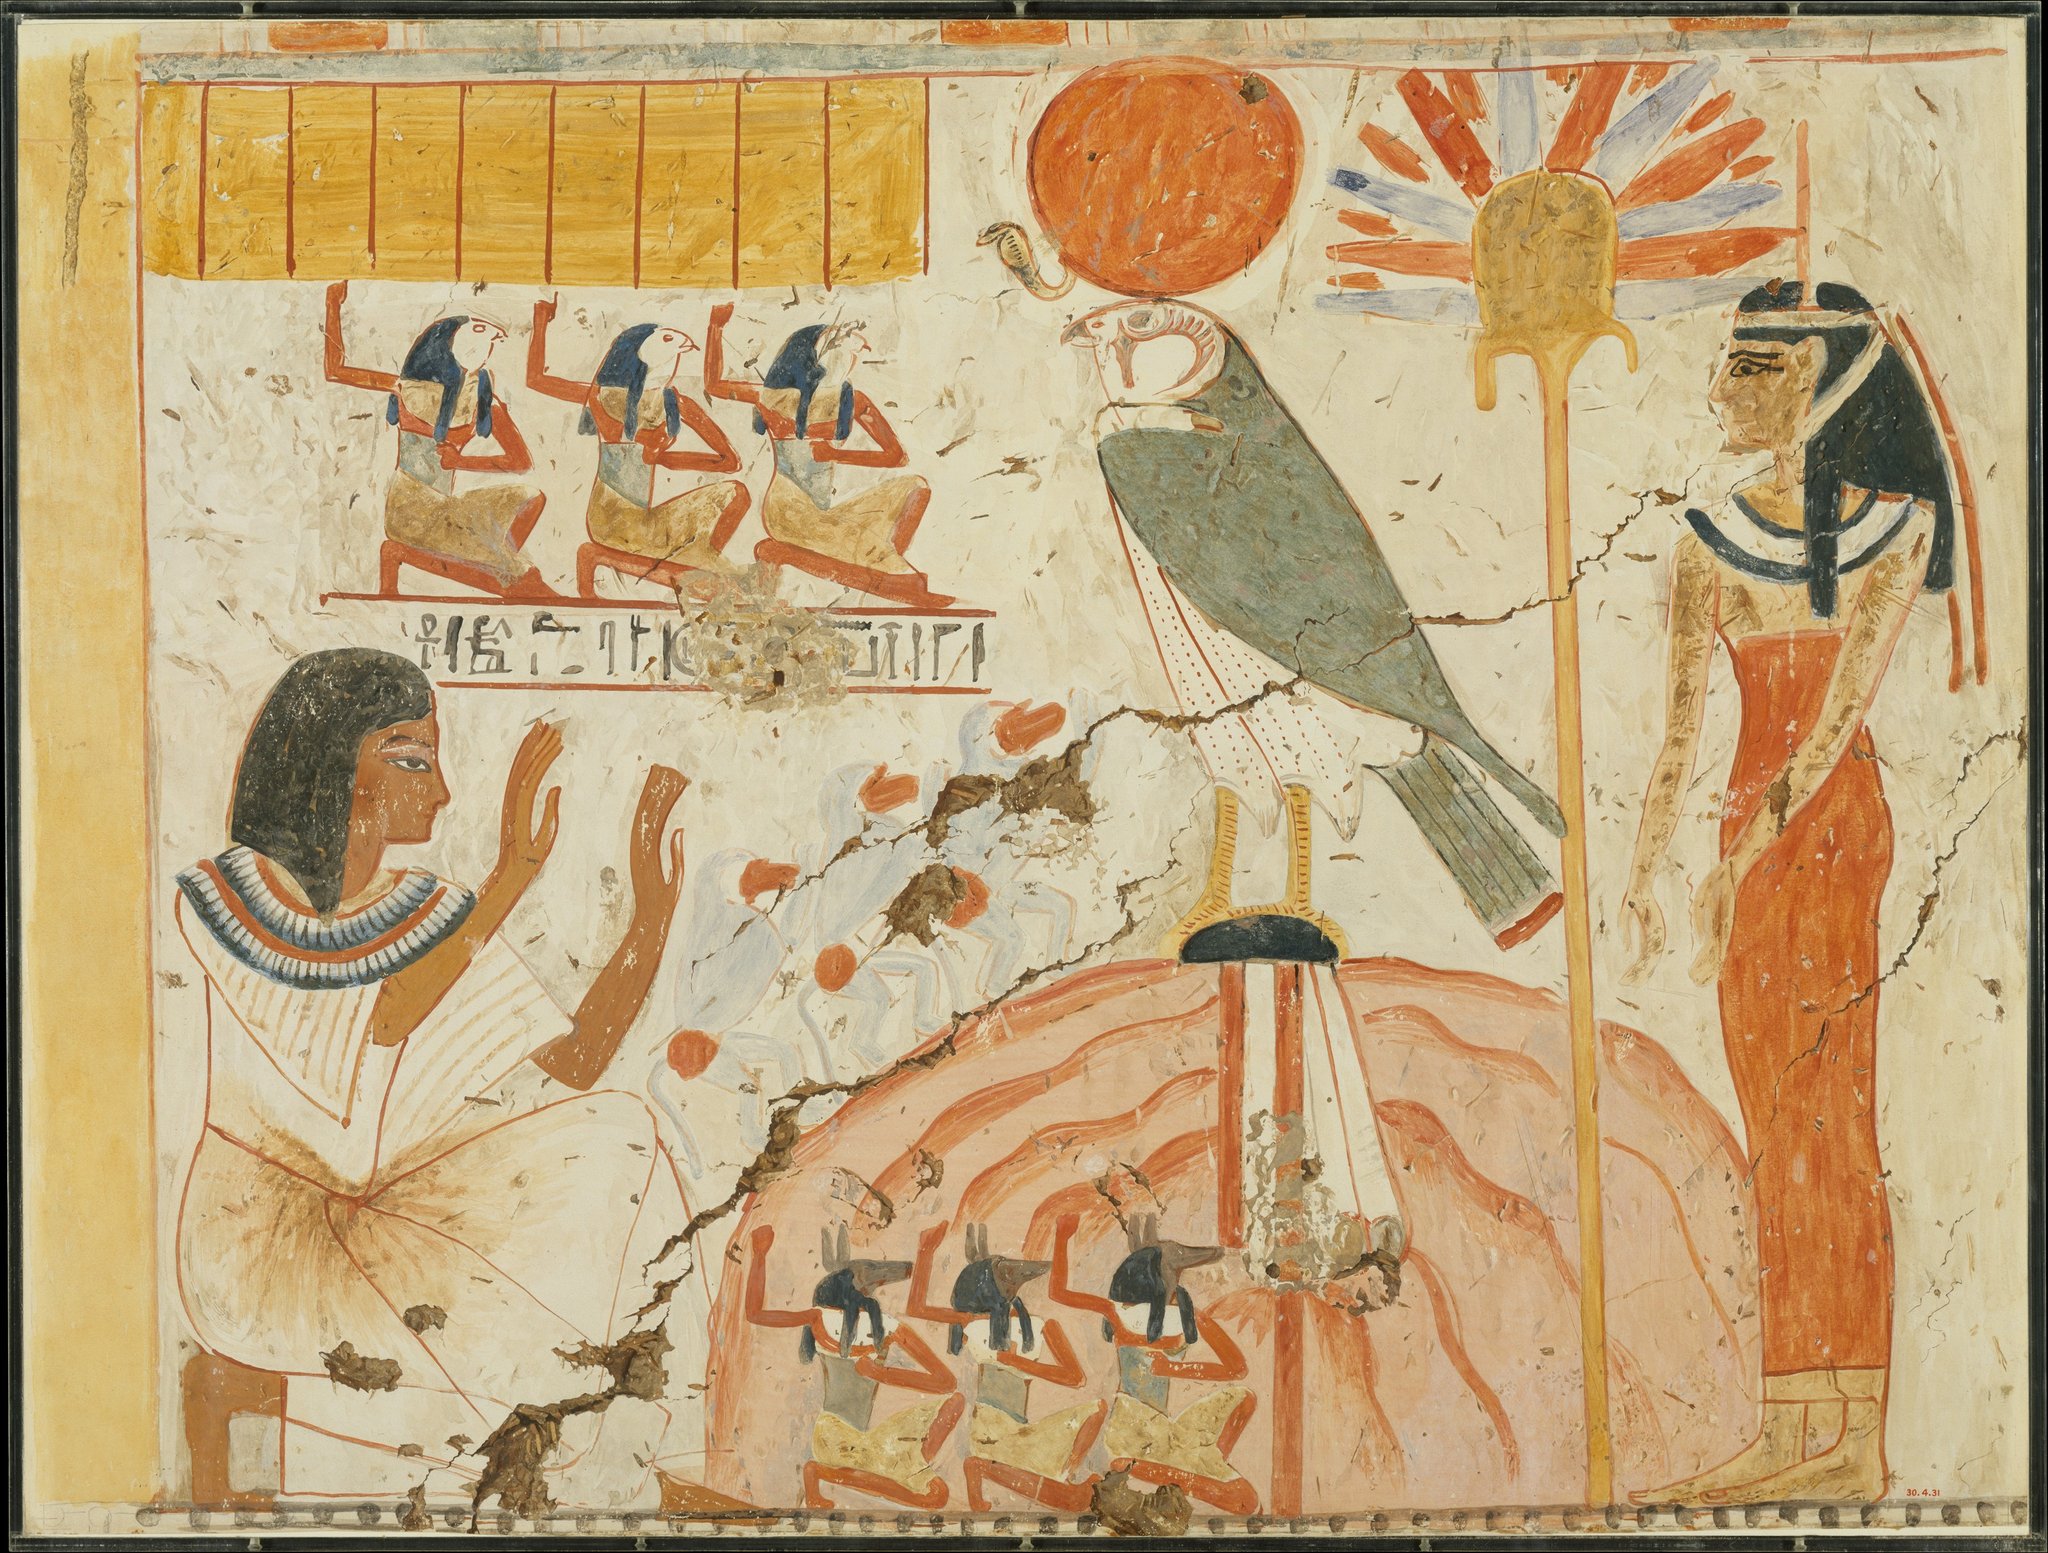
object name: facsimile, userhat tt 51, adoration, western god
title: Userhat Adoring Deities of the West, Tomb of Userhat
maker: norman de garis davies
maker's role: artist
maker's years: 1865-1941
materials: paper, paint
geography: egypt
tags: falcons,men,women,hieroglyphs